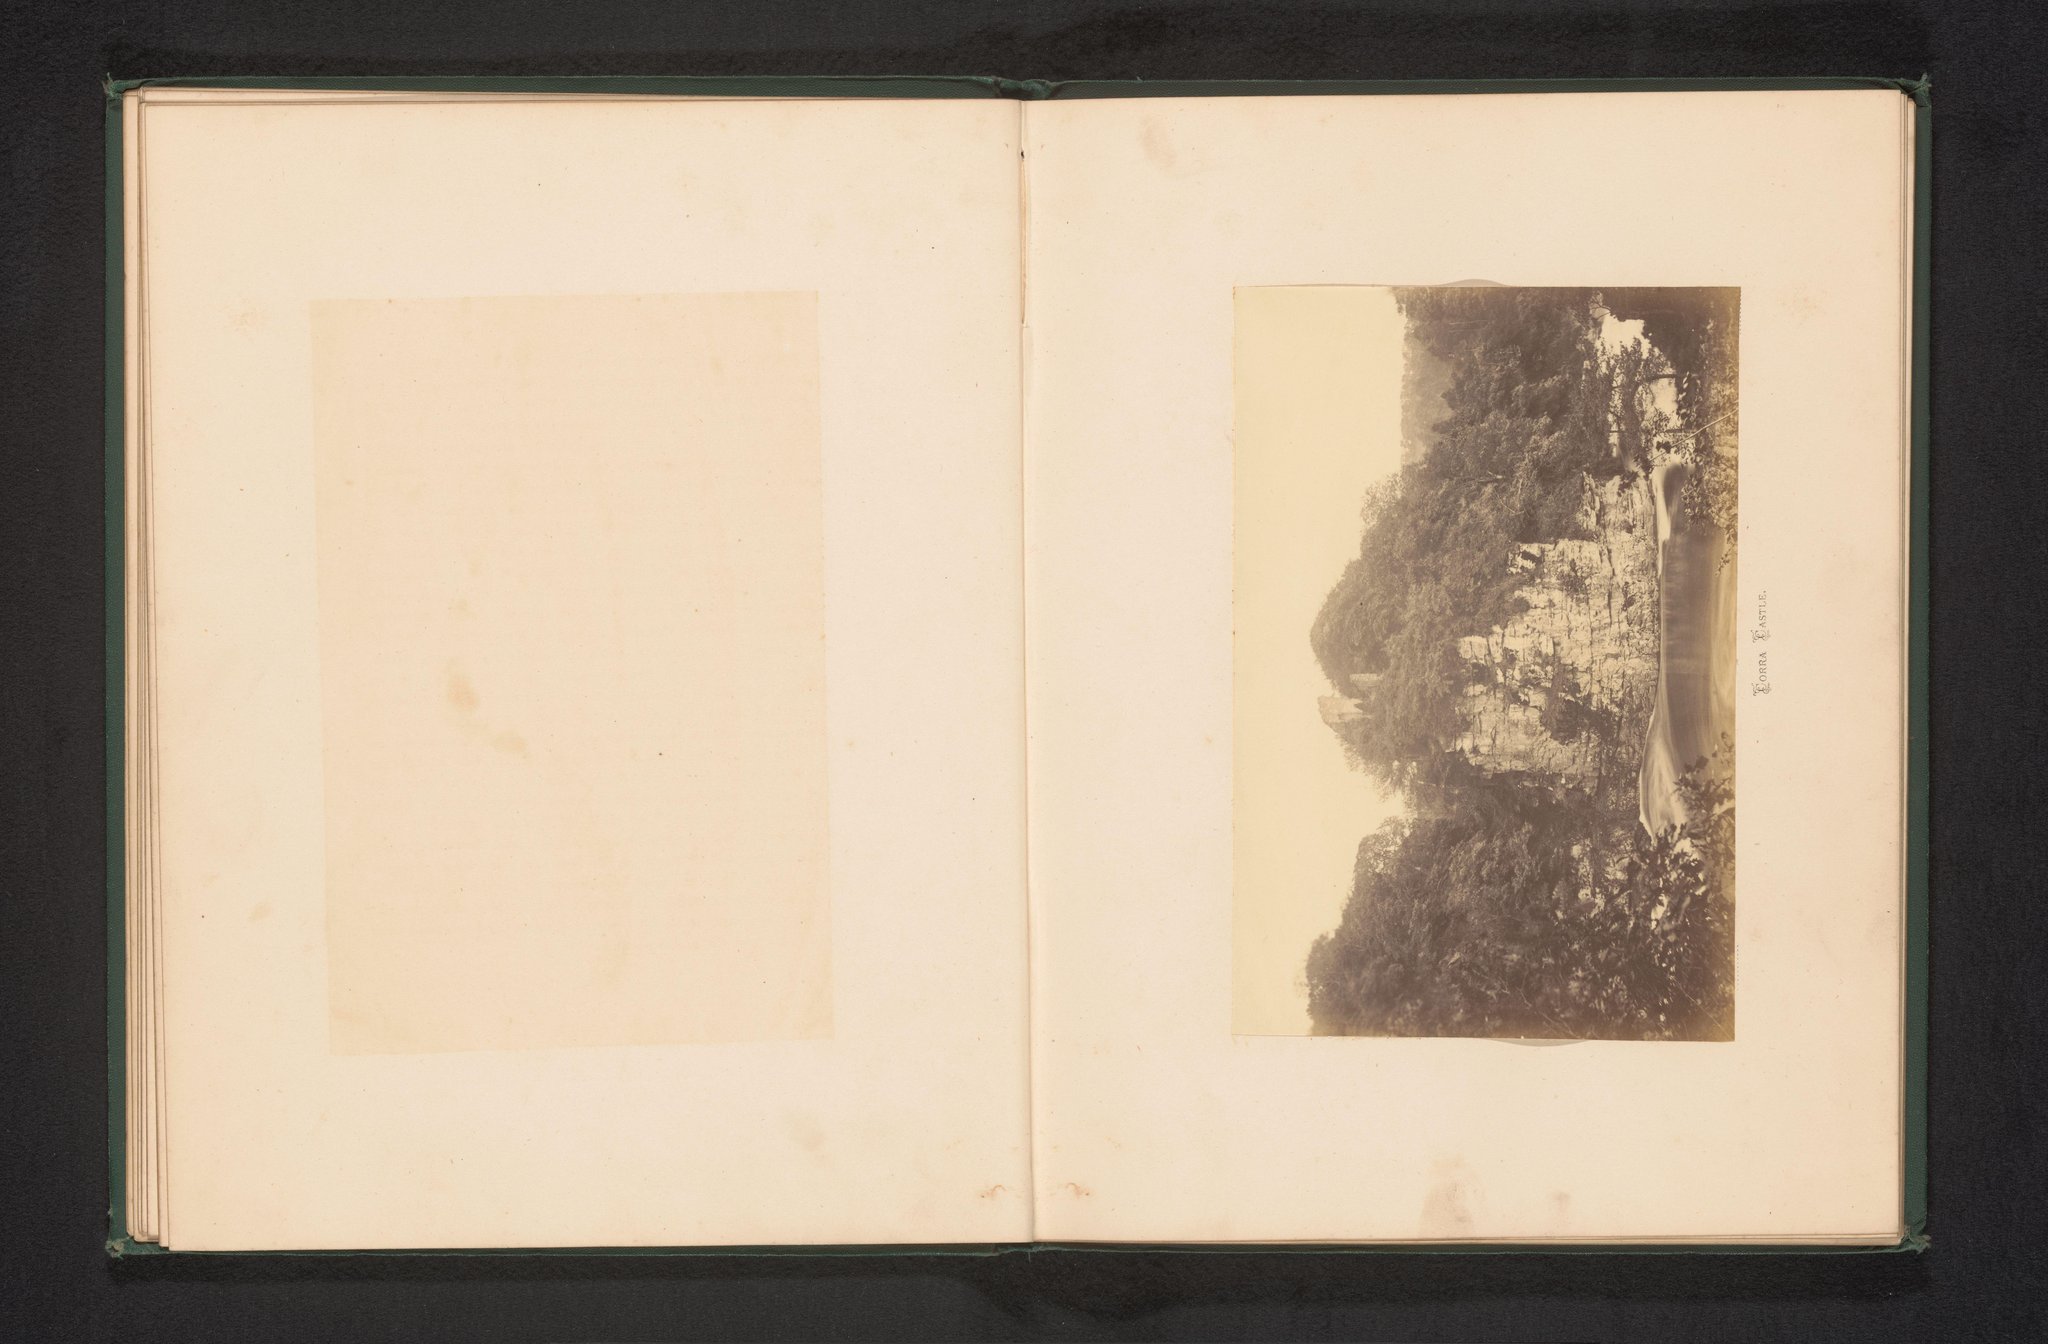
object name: photograph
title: Corra Castle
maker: Anonymous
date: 1862-1867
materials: photographic support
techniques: albumen print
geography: south lanarkshire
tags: castle, river, landscape with tower or castle